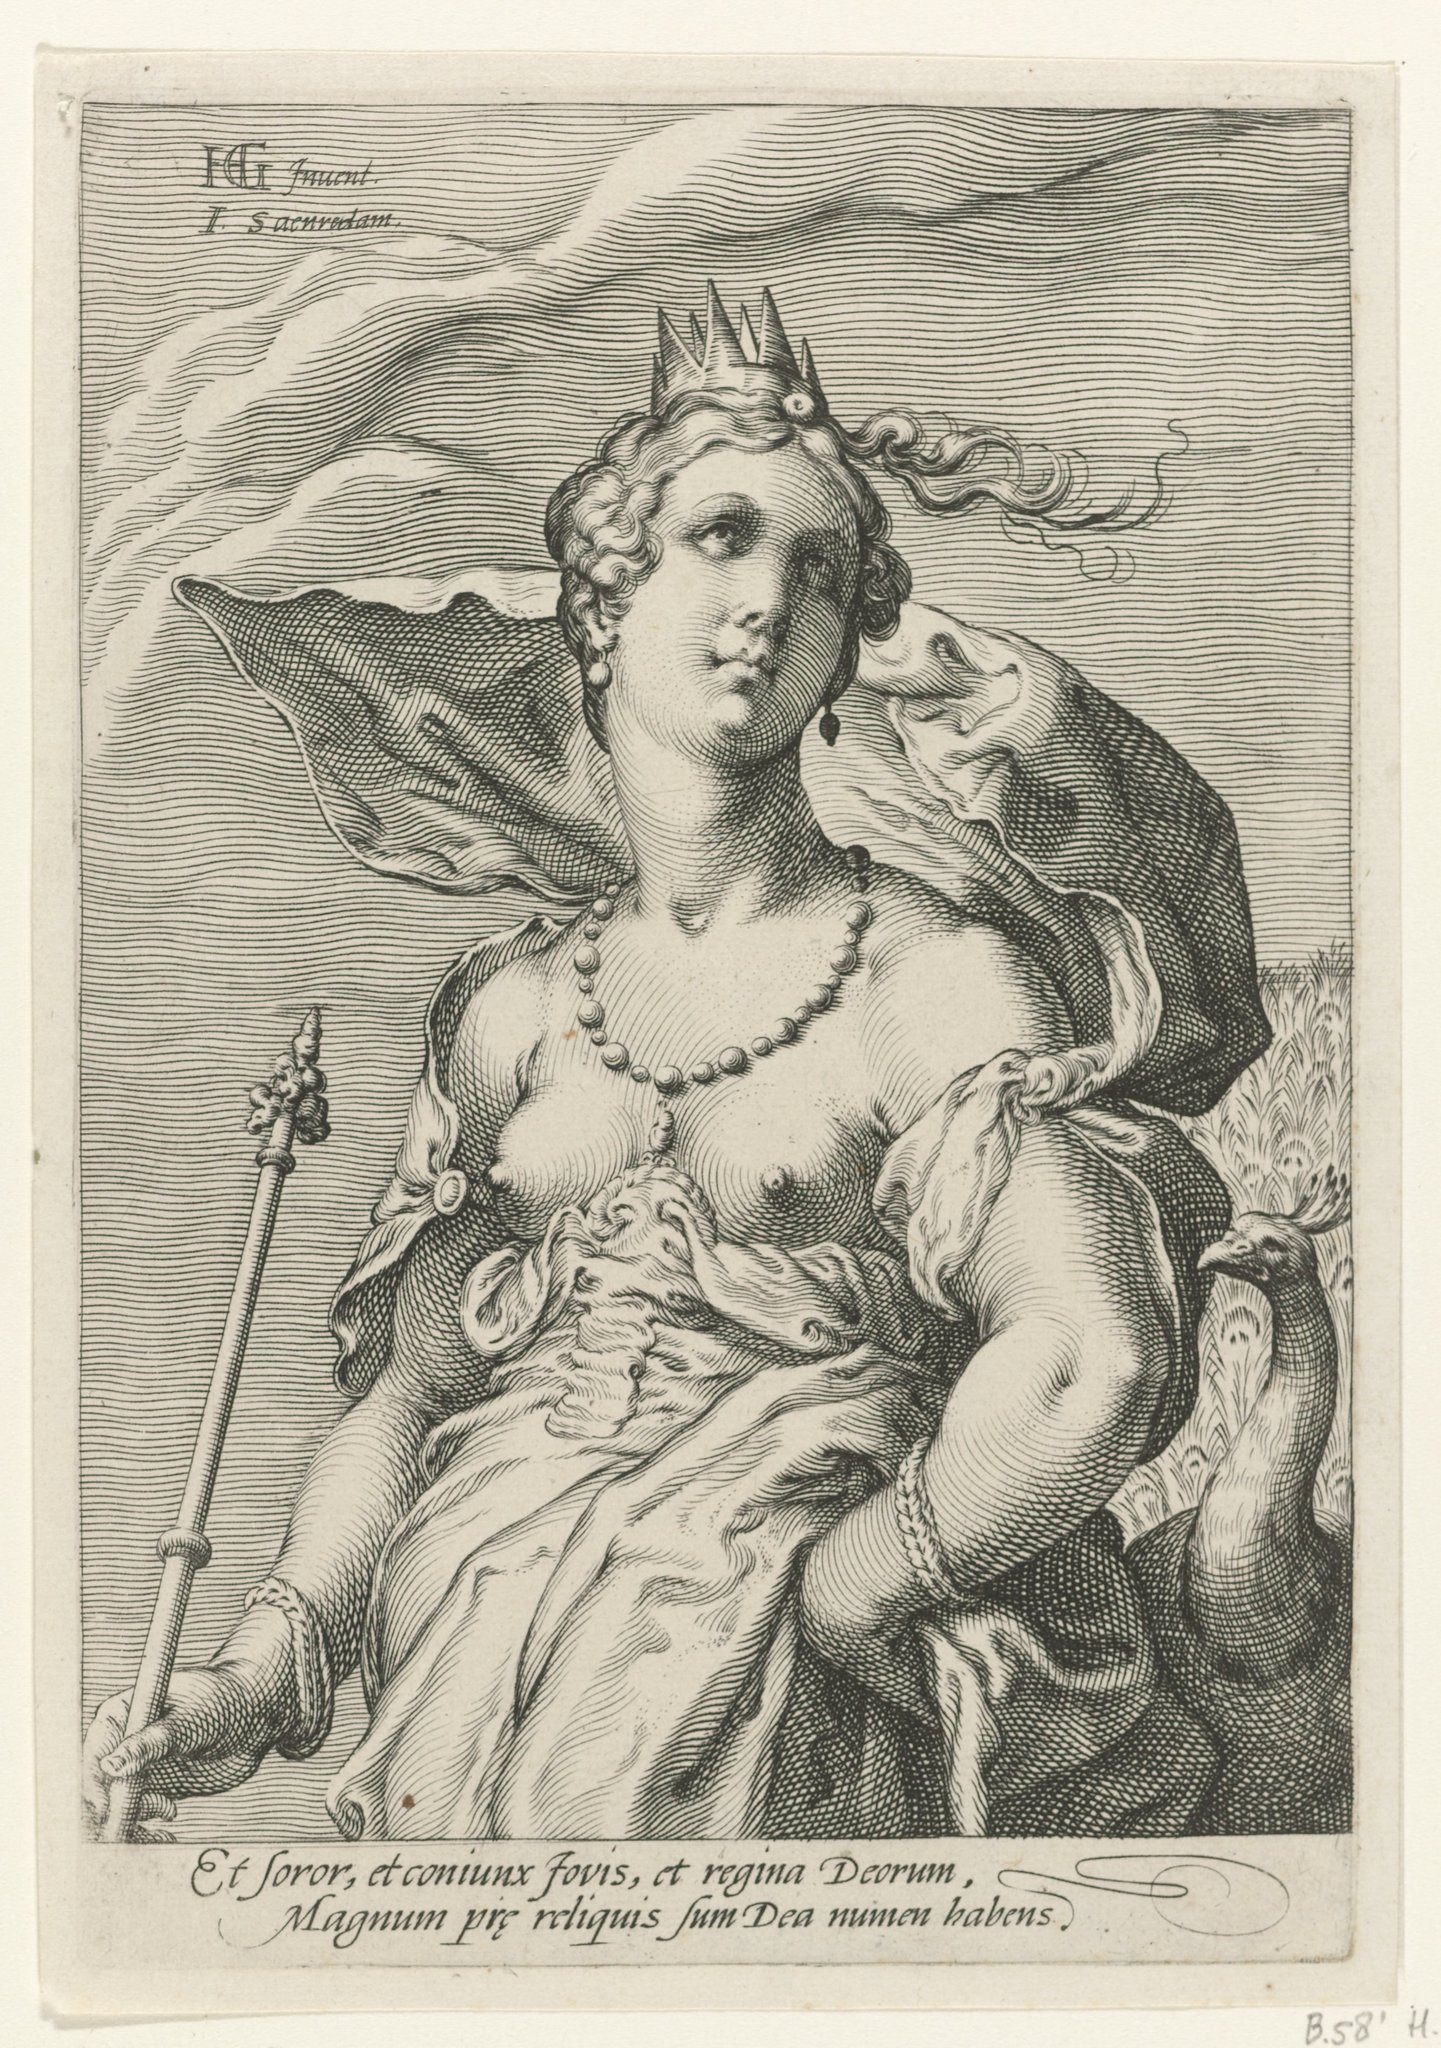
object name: print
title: Juno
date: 1575-1607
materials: paper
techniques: engraving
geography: northern netherlands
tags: (story of) juno (hera), the judgement of paris (without mercury), attributes of juno (with name)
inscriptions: collector's mark: Lugt 240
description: De godin Juno, met een kroon op haar hoofd. Naast haar een pauw, haar attribuut. De prent is deel van een driedelige serie met de drie godinnen van het oordeel van Paris en heeft een Latijns onderschrift.